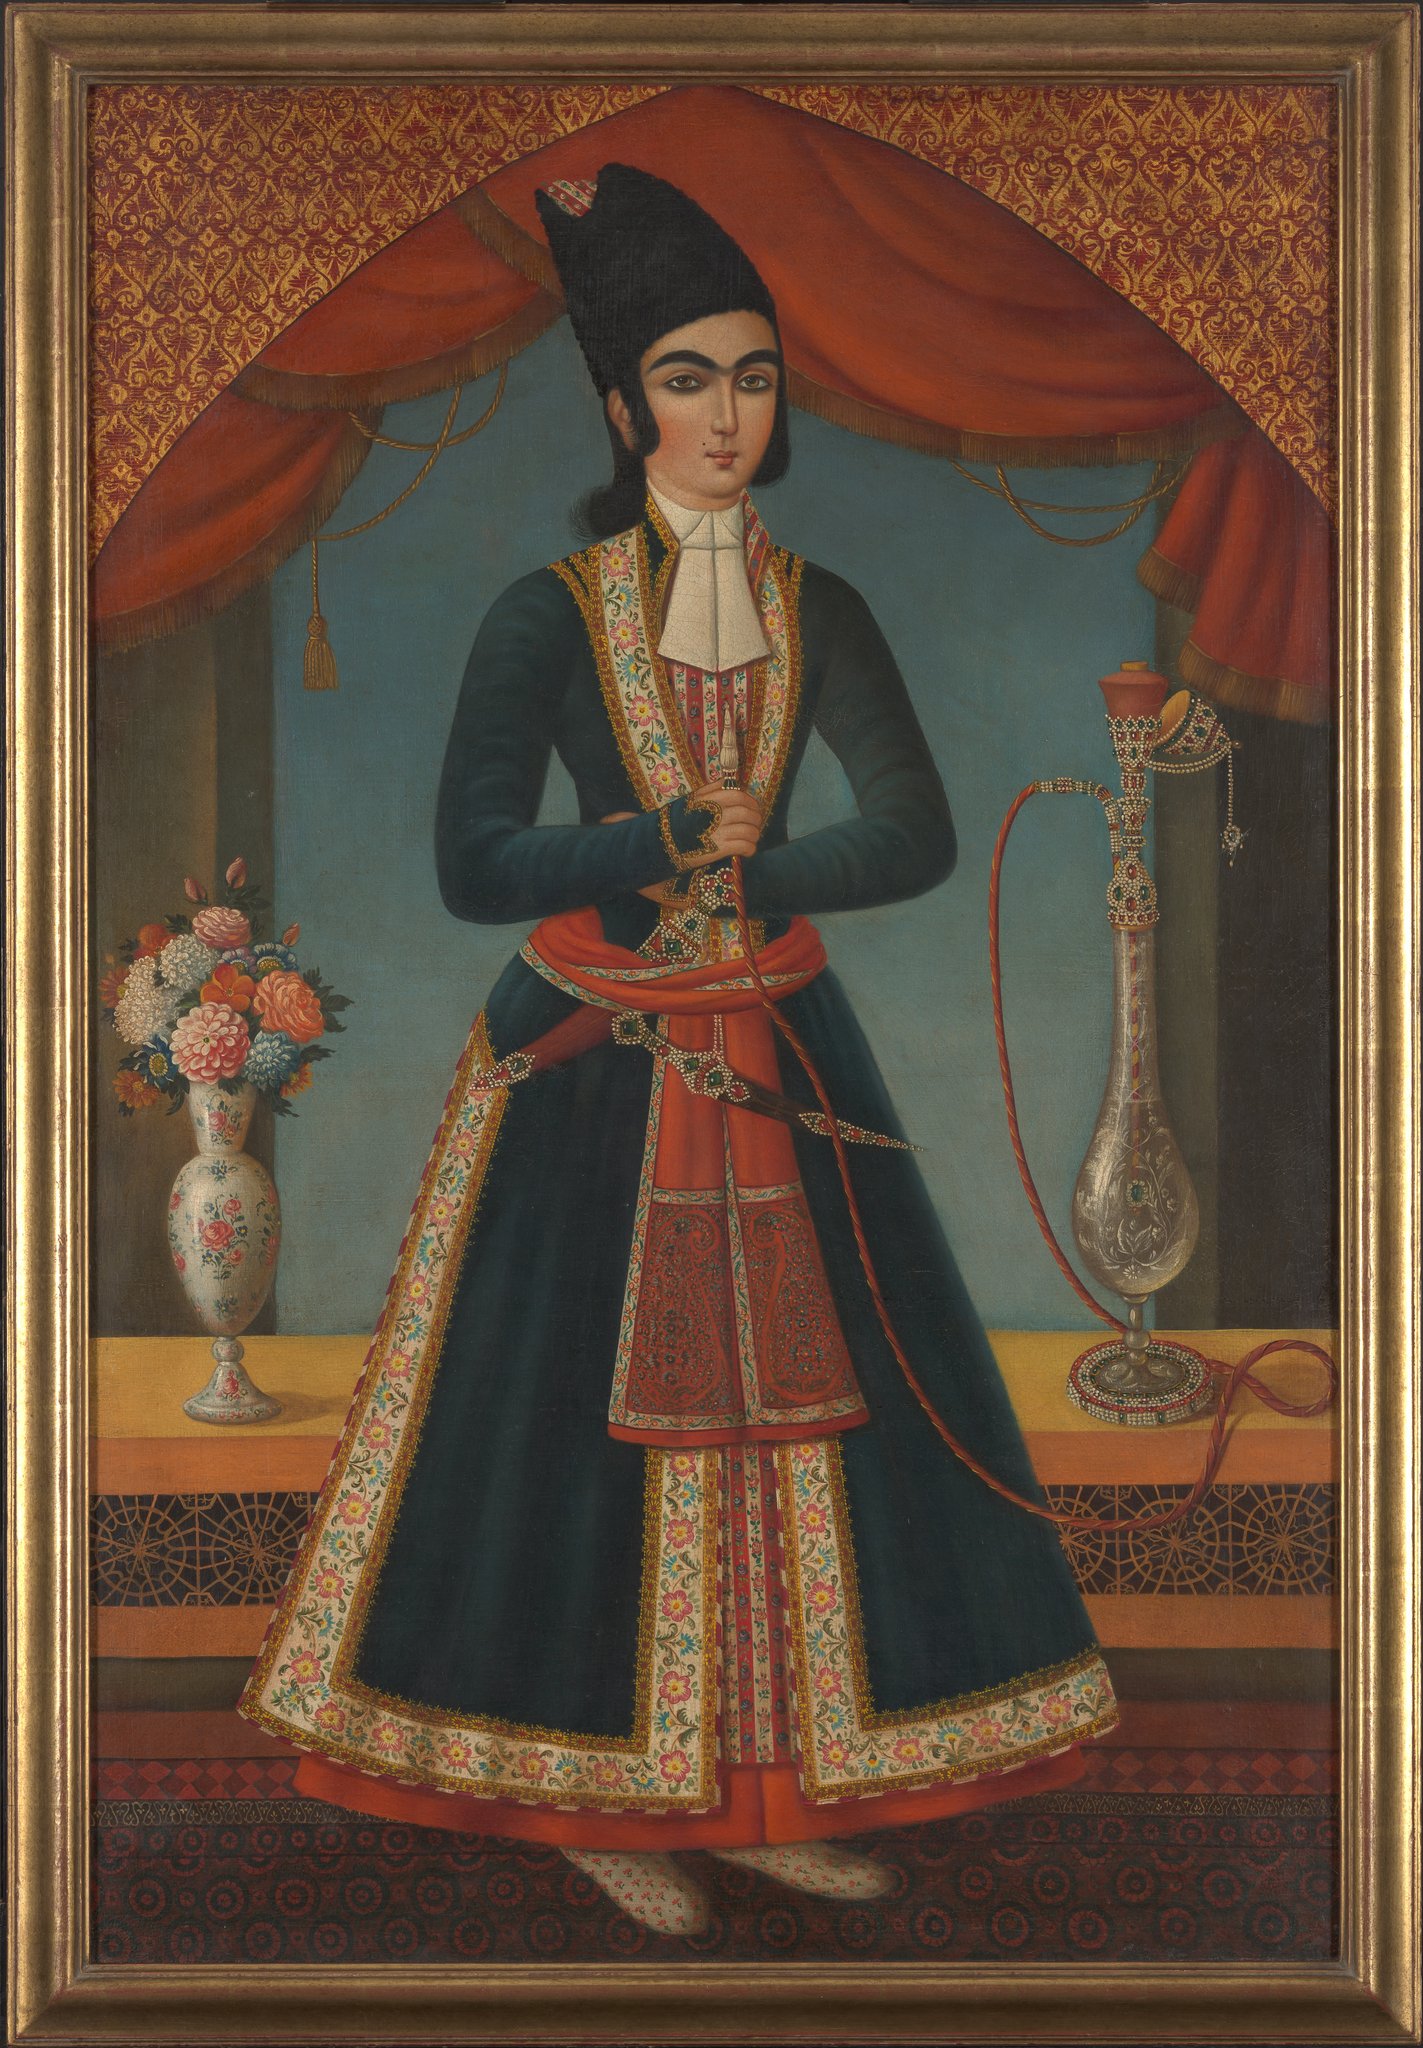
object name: painting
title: A Young Prince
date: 1820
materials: canvas, oil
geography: iran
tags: princes,men,portraits,hookah